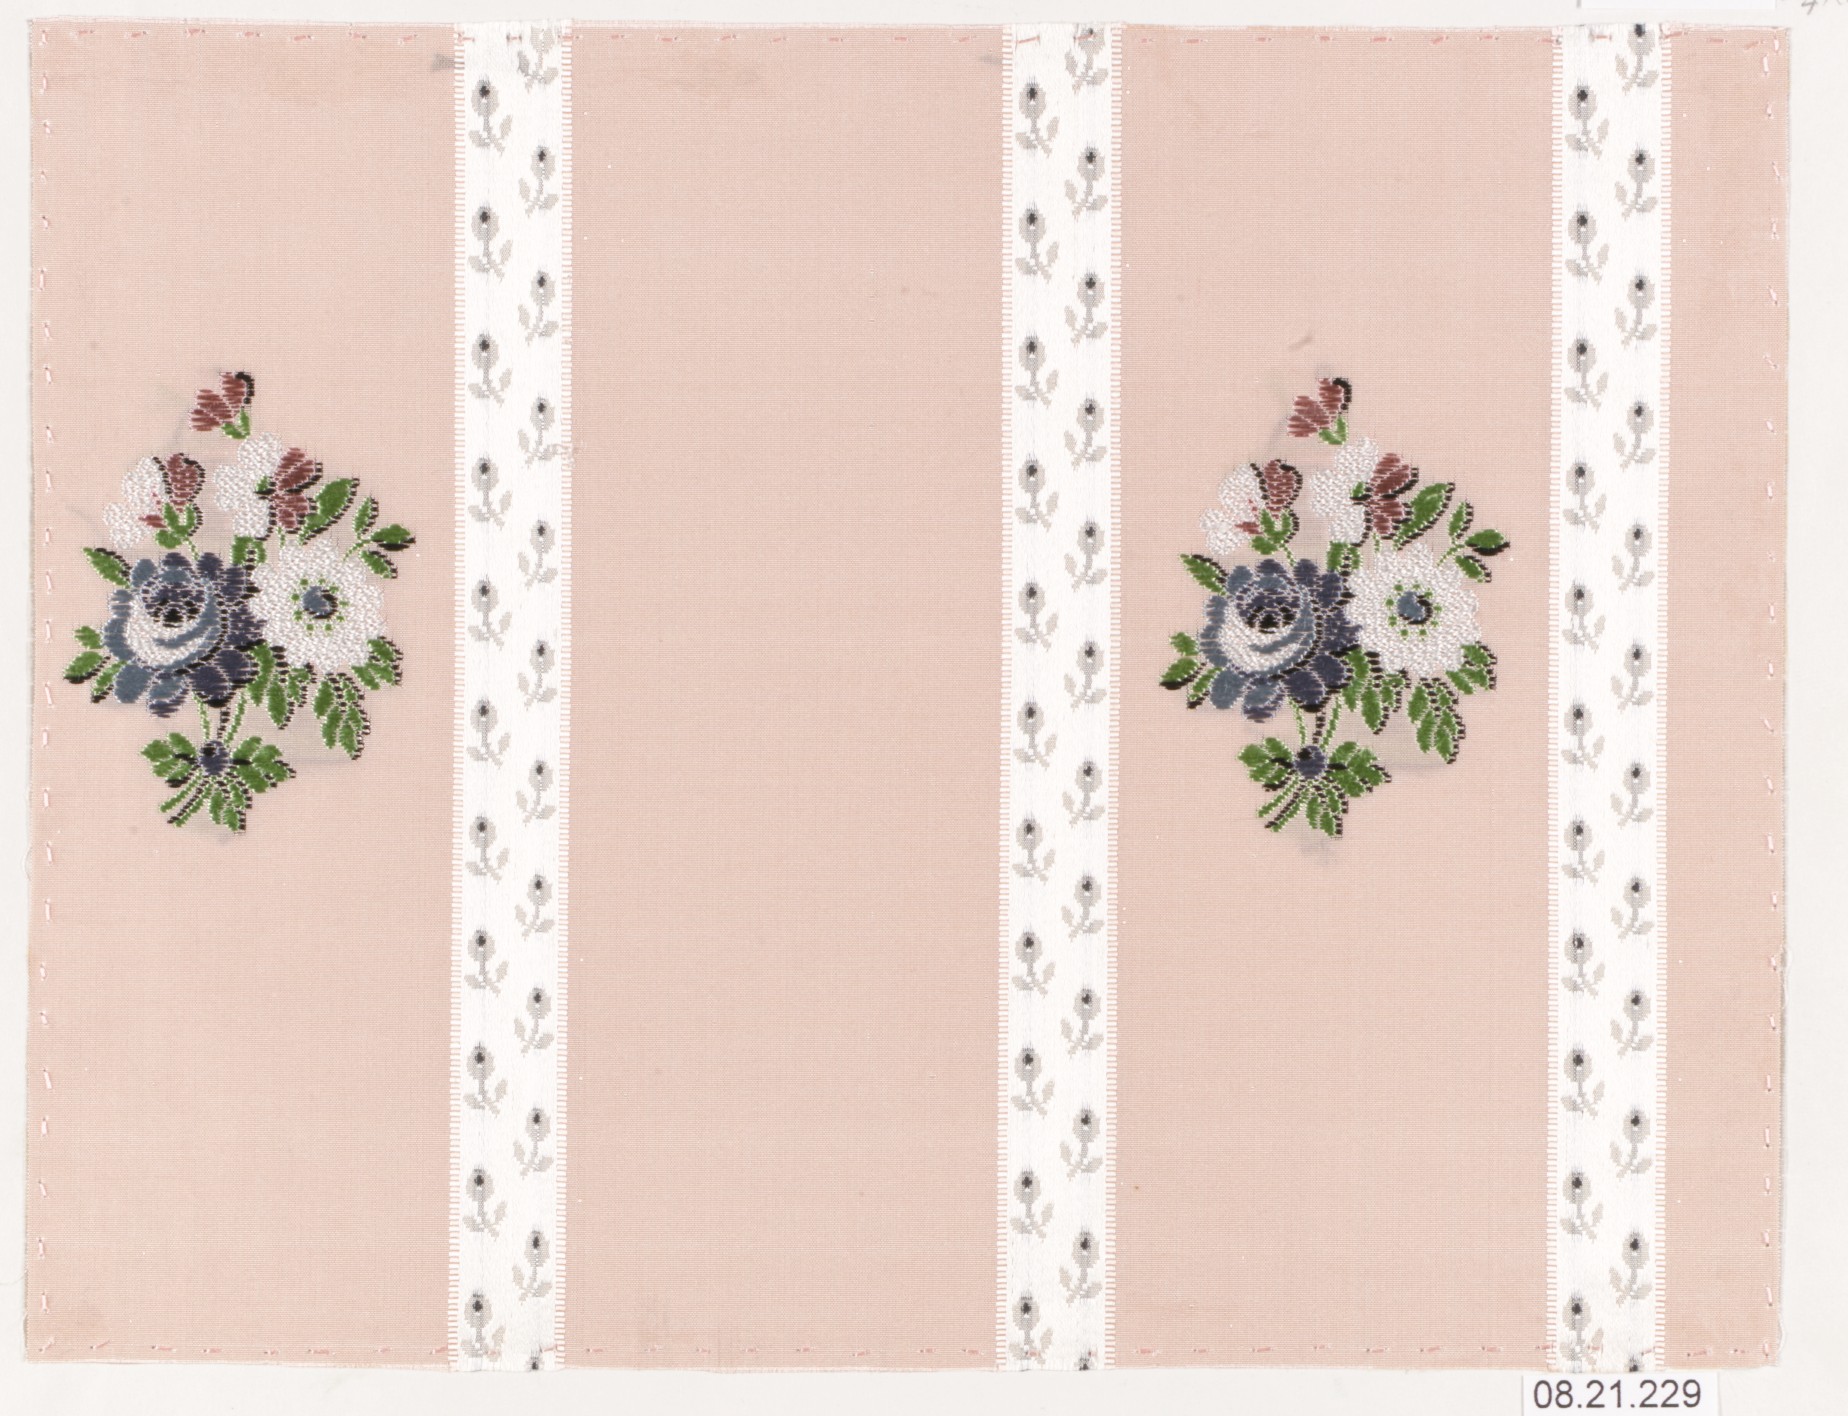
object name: textile sample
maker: Anonymous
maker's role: designer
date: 1900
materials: silk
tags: flowers